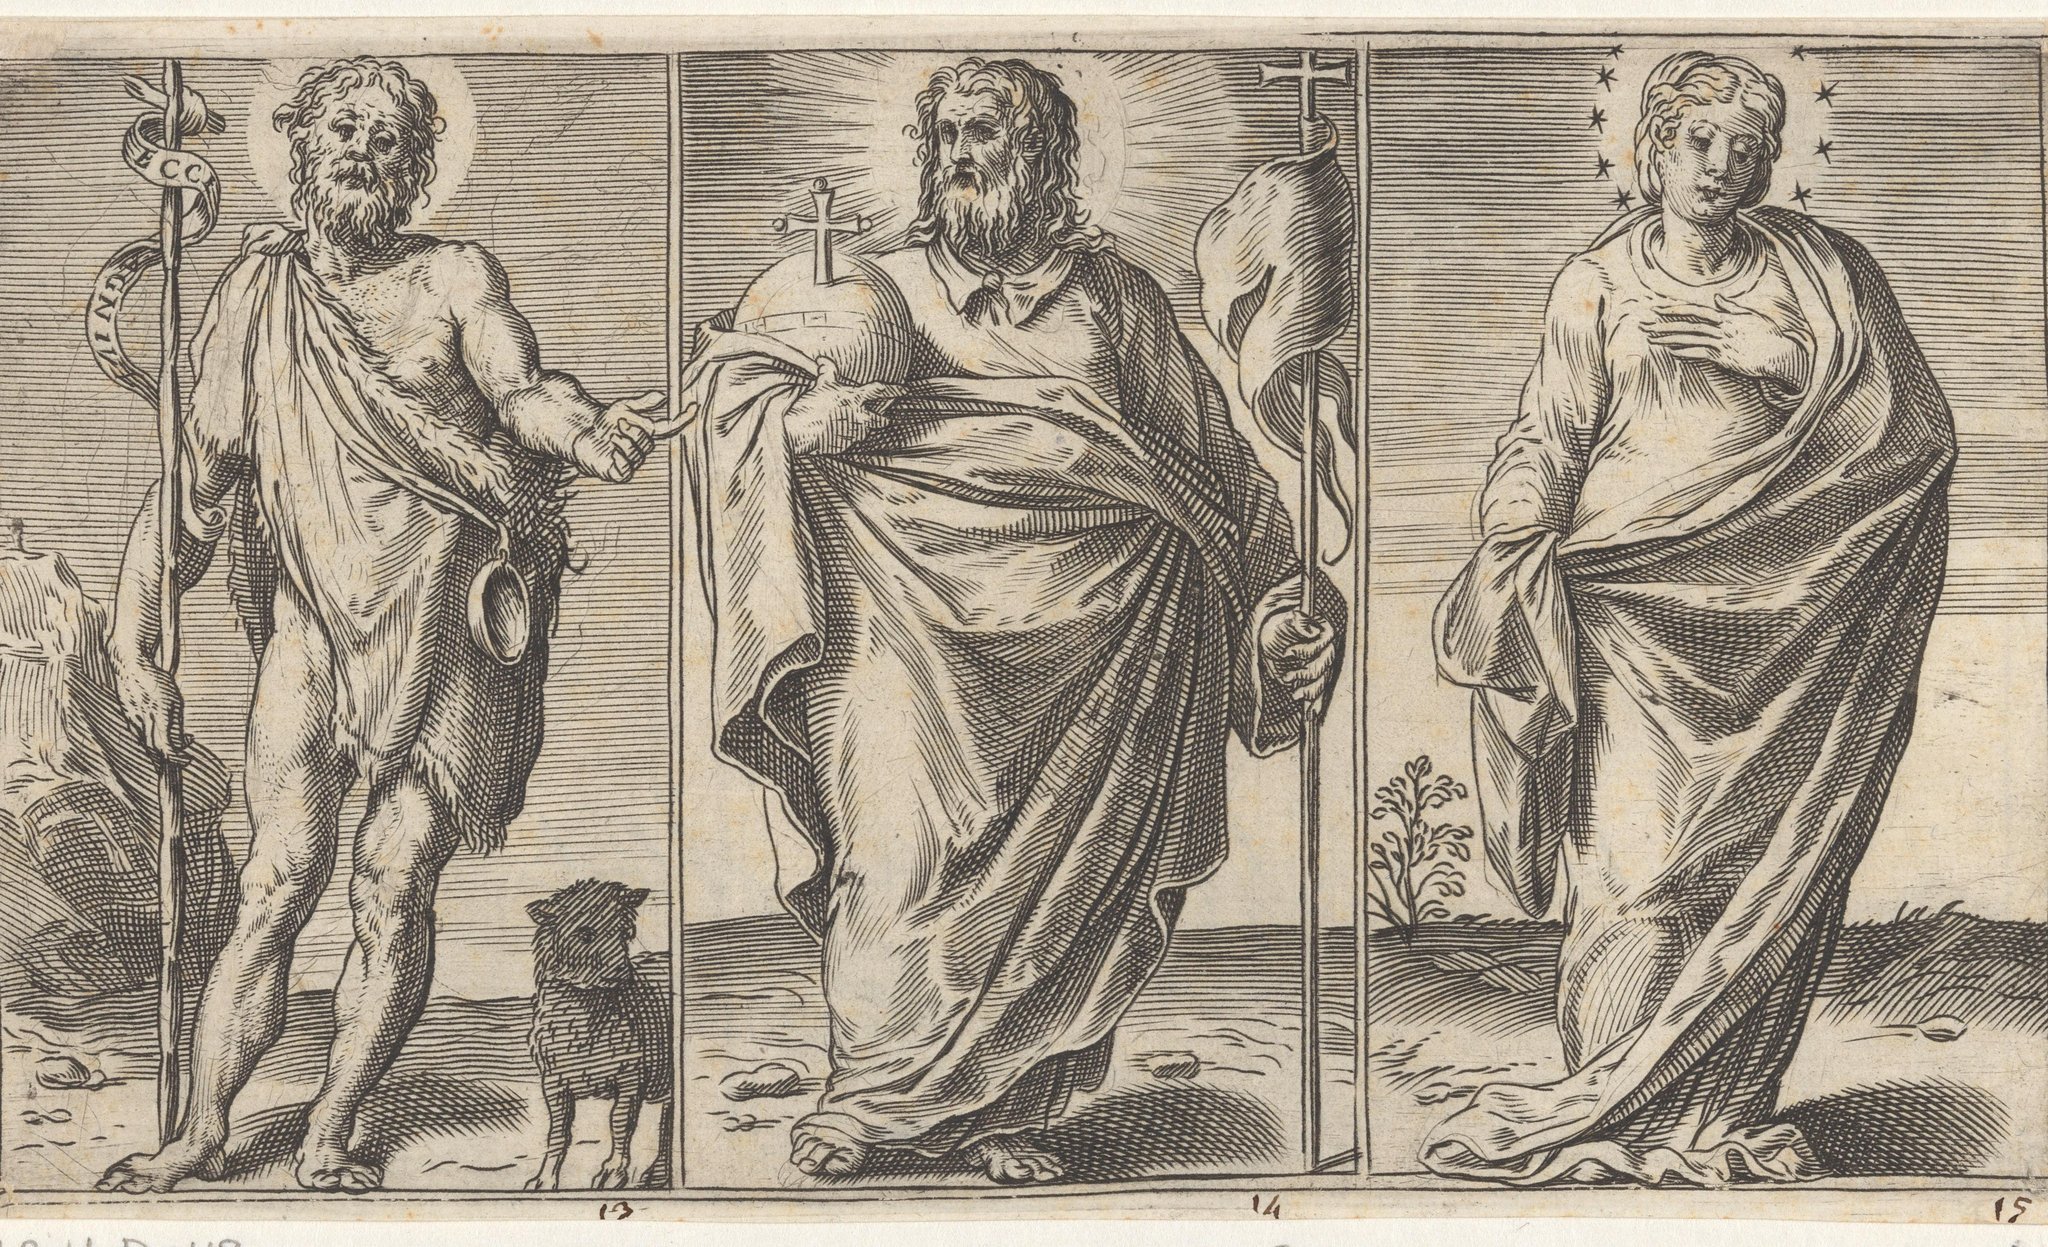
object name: print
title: Christus, Maria, Johannes de Doper en de apostelen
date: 1583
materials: paper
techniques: engraving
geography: italy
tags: other types of mary (alone), john the baptist; possible attributes: book, reed cross, baptismal cup, honeycomb, lamb, staff, 'salvator mundi', making a blessing gesture; an orb in his hand or at his feet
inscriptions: collector's mark: ‘Hinloopen’, number: ‘13 / 14 / 15’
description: Blad met drie voorstellingen van Johannes de Doper met staf en lam, van Christus als Salvator Mundi en van Maria met een krans van sterren.